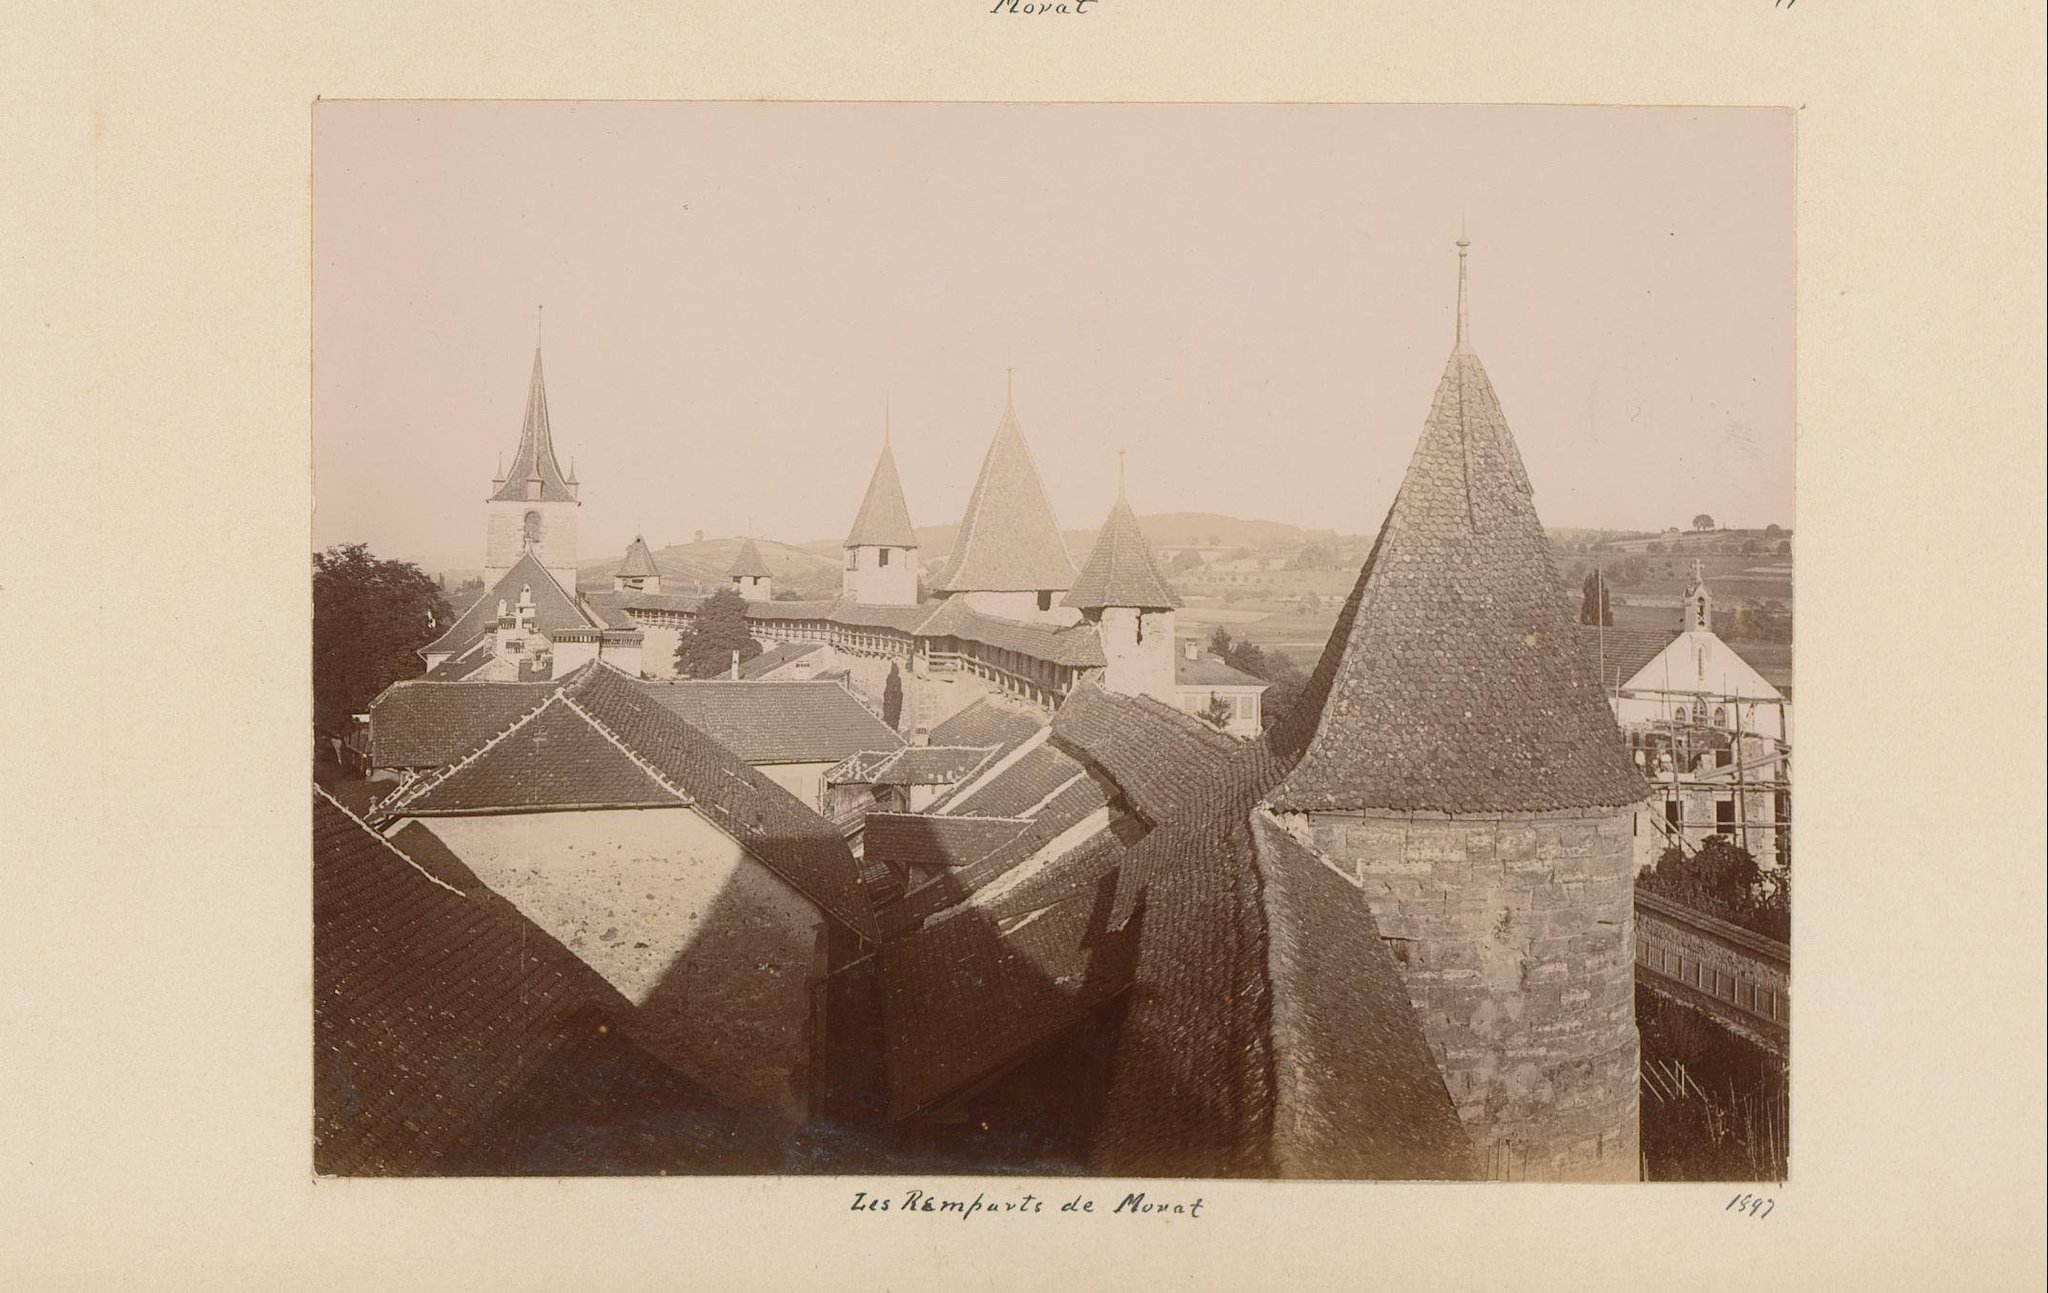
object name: photograph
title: Gezicht op de stadsmuur van Murten te Zwitserland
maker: Anonymous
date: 1897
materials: cardboard, photographic support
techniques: gelatin silver print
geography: murten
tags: city-walls (+ city(-scape) with figures, staffage)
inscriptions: annotation: ‘Les Remparts de Morat 1897’